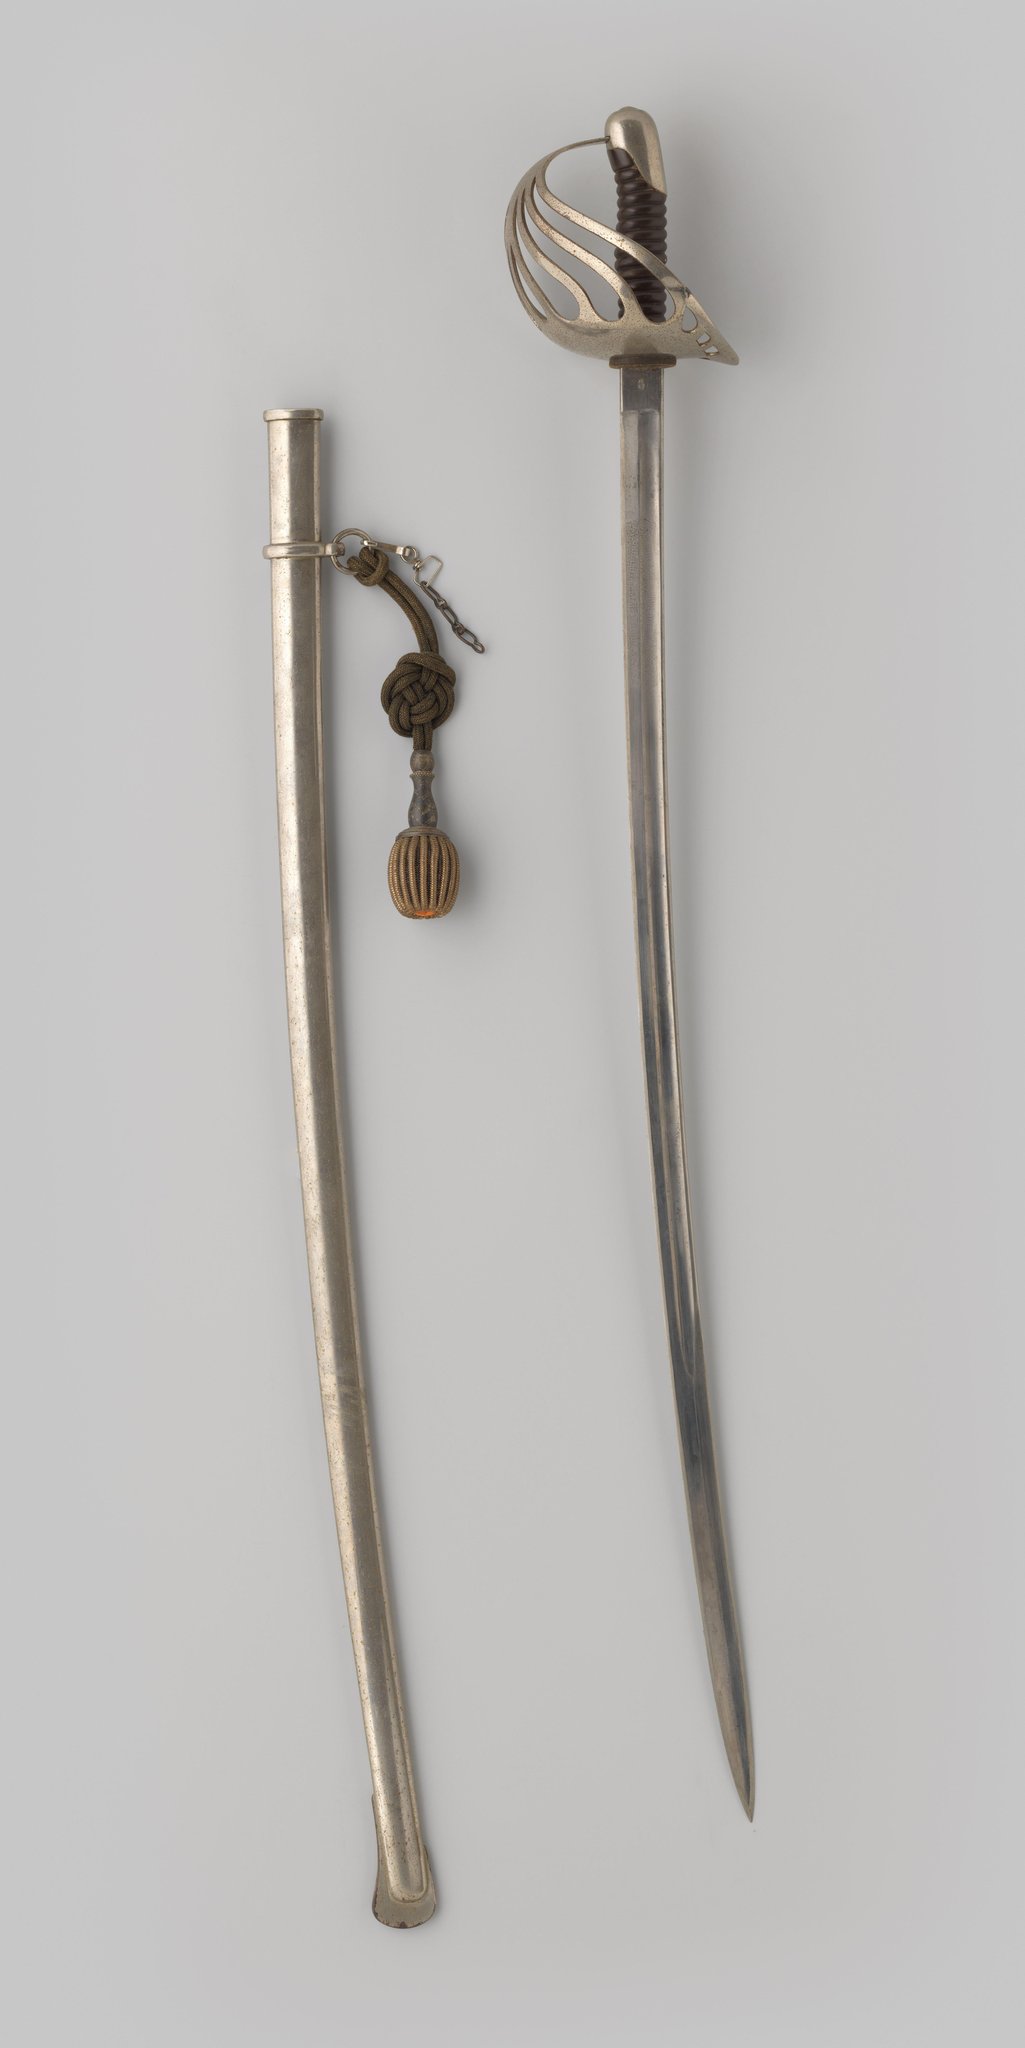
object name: sabre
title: Cavaleriesabel reserve-officier D. Schipper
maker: Anonymous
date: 1800-1899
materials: steel, textile, wood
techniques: engraving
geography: breda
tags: militair, dirk schipper, atjeh, atjeh-oorlog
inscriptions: inscription: ‘VK’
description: Stalen cavaleriesabel van reserve-officier D. Schipper. Stalen schede met een losse ring waaraan een gele sabelkwast hang aan een bruingeel koord. De kling heeft een bloedgeul en is gegraveerd met motieven en de naam van de vervaardiger. Het gevest heeft een gesloten stootplaat met zes beugels. Op het ricasso keurmerken. De greep is geribbeld en van leer.